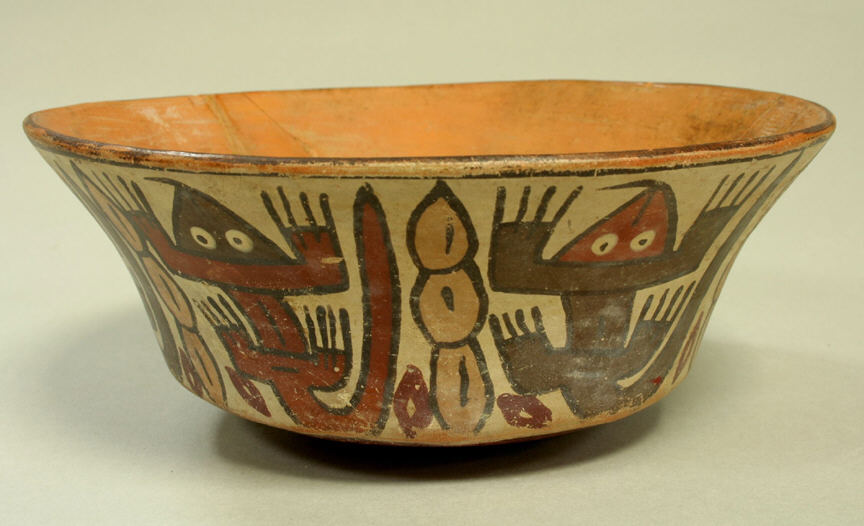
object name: bowl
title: Painted Bowl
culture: nasca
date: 1-600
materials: ceramic, pigment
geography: peru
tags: lizards